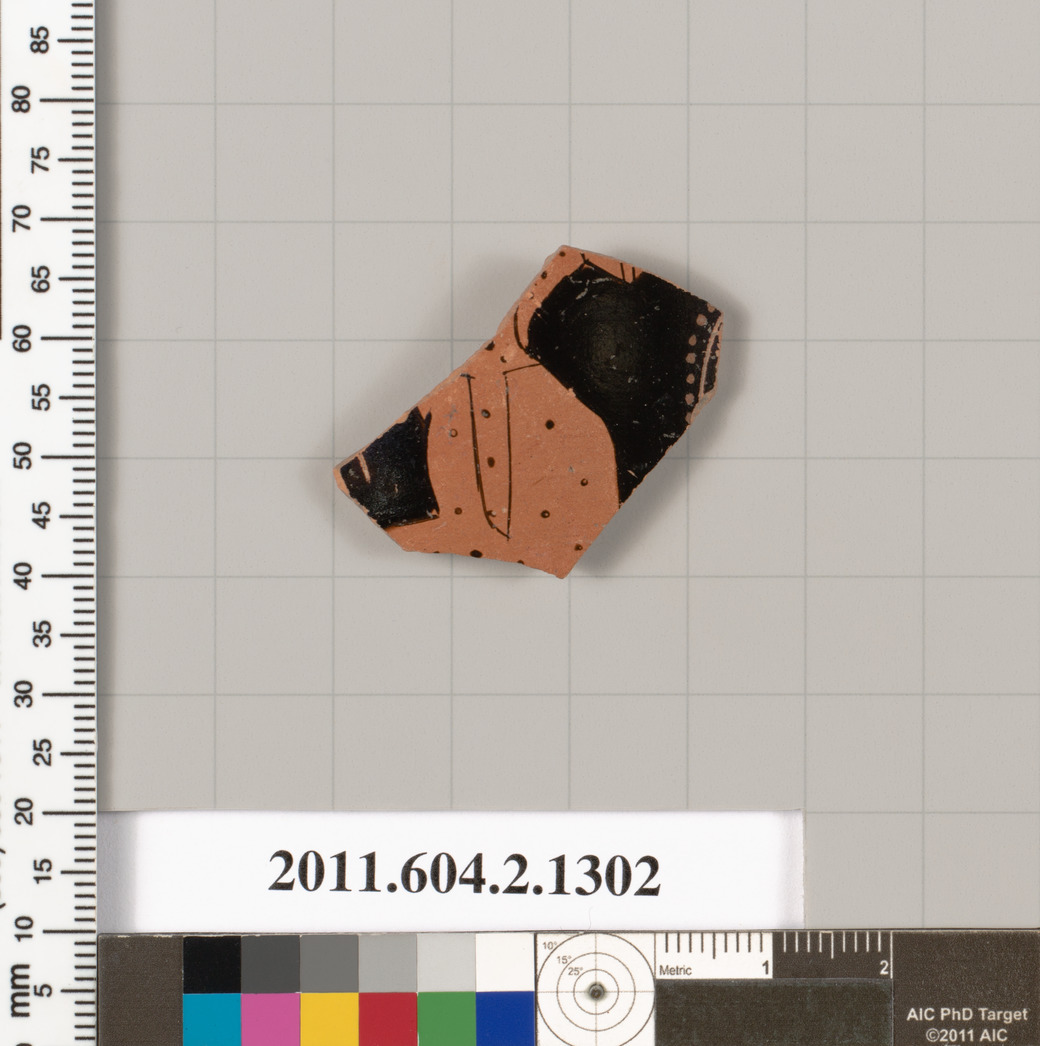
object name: skyphos fragment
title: Terracotta fragment of a skyphos (deep drinking cup)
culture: greek, attic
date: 450-430 BCE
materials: terracotta